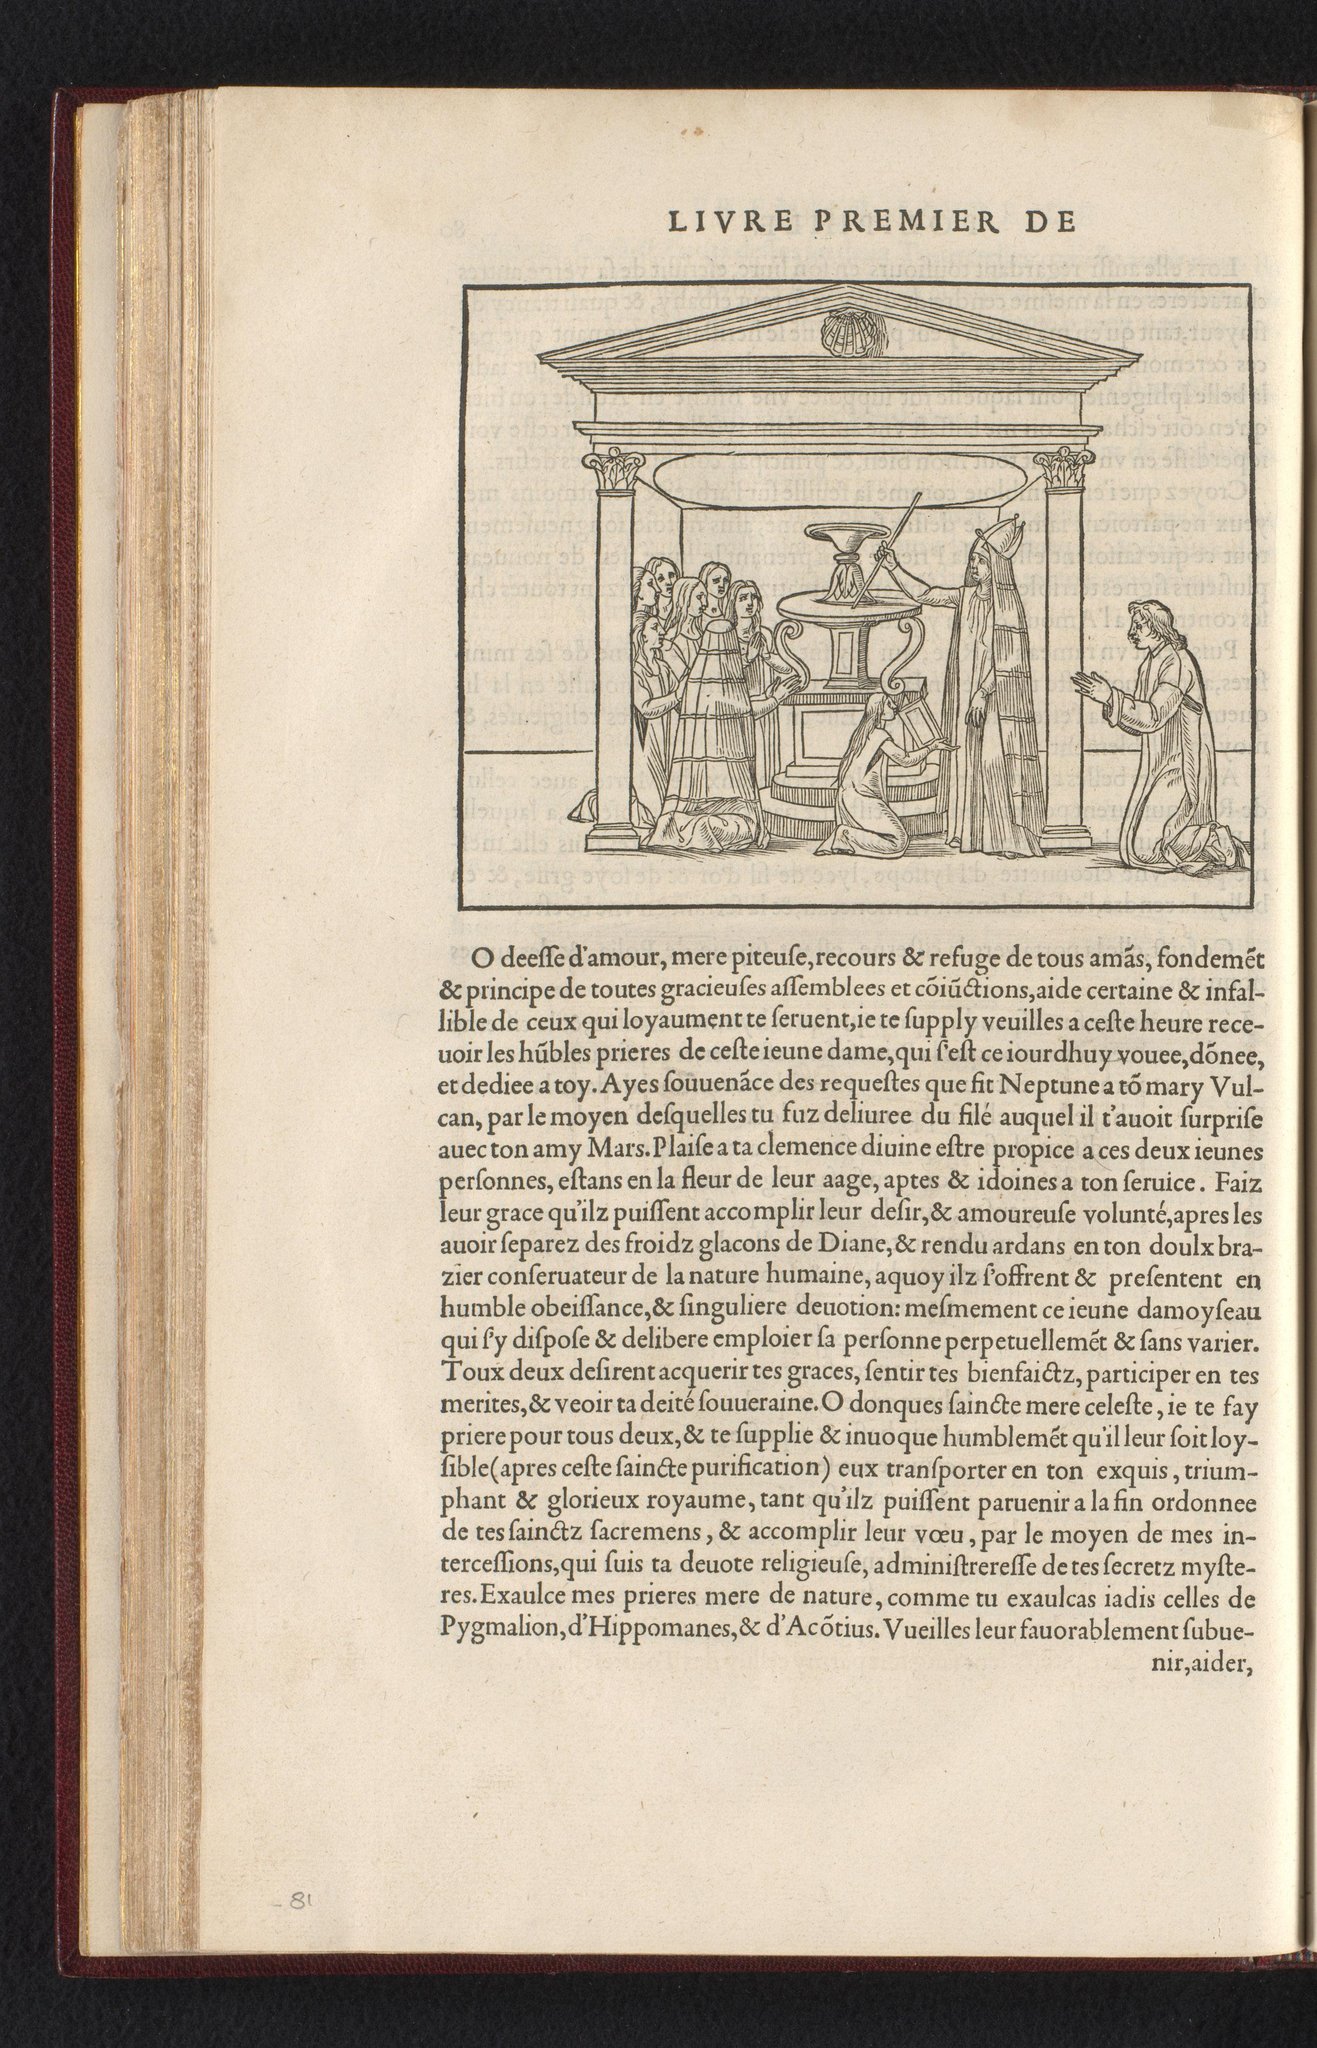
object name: print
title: Polia en Poliphilo aan weerszijden van een altaar knielend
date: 1546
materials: paper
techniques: letterpress printing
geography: paris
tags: altar ~ non-christian religions, priest ~ greek religion - ee - priestess, (scenes from) specific works of literature: colonna, hypnerotomachia poliphili, kneeling on both knees - aa - female human figure, kneeling on both knees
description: Prent uit: Colonna, Francesco. Hypnerotomachie ou discours du songe de Poliphile, deduisant comme amour le combat a l'occasion de Polia. Parijs: Jacques Kerver, 1546, verso fol. 80.